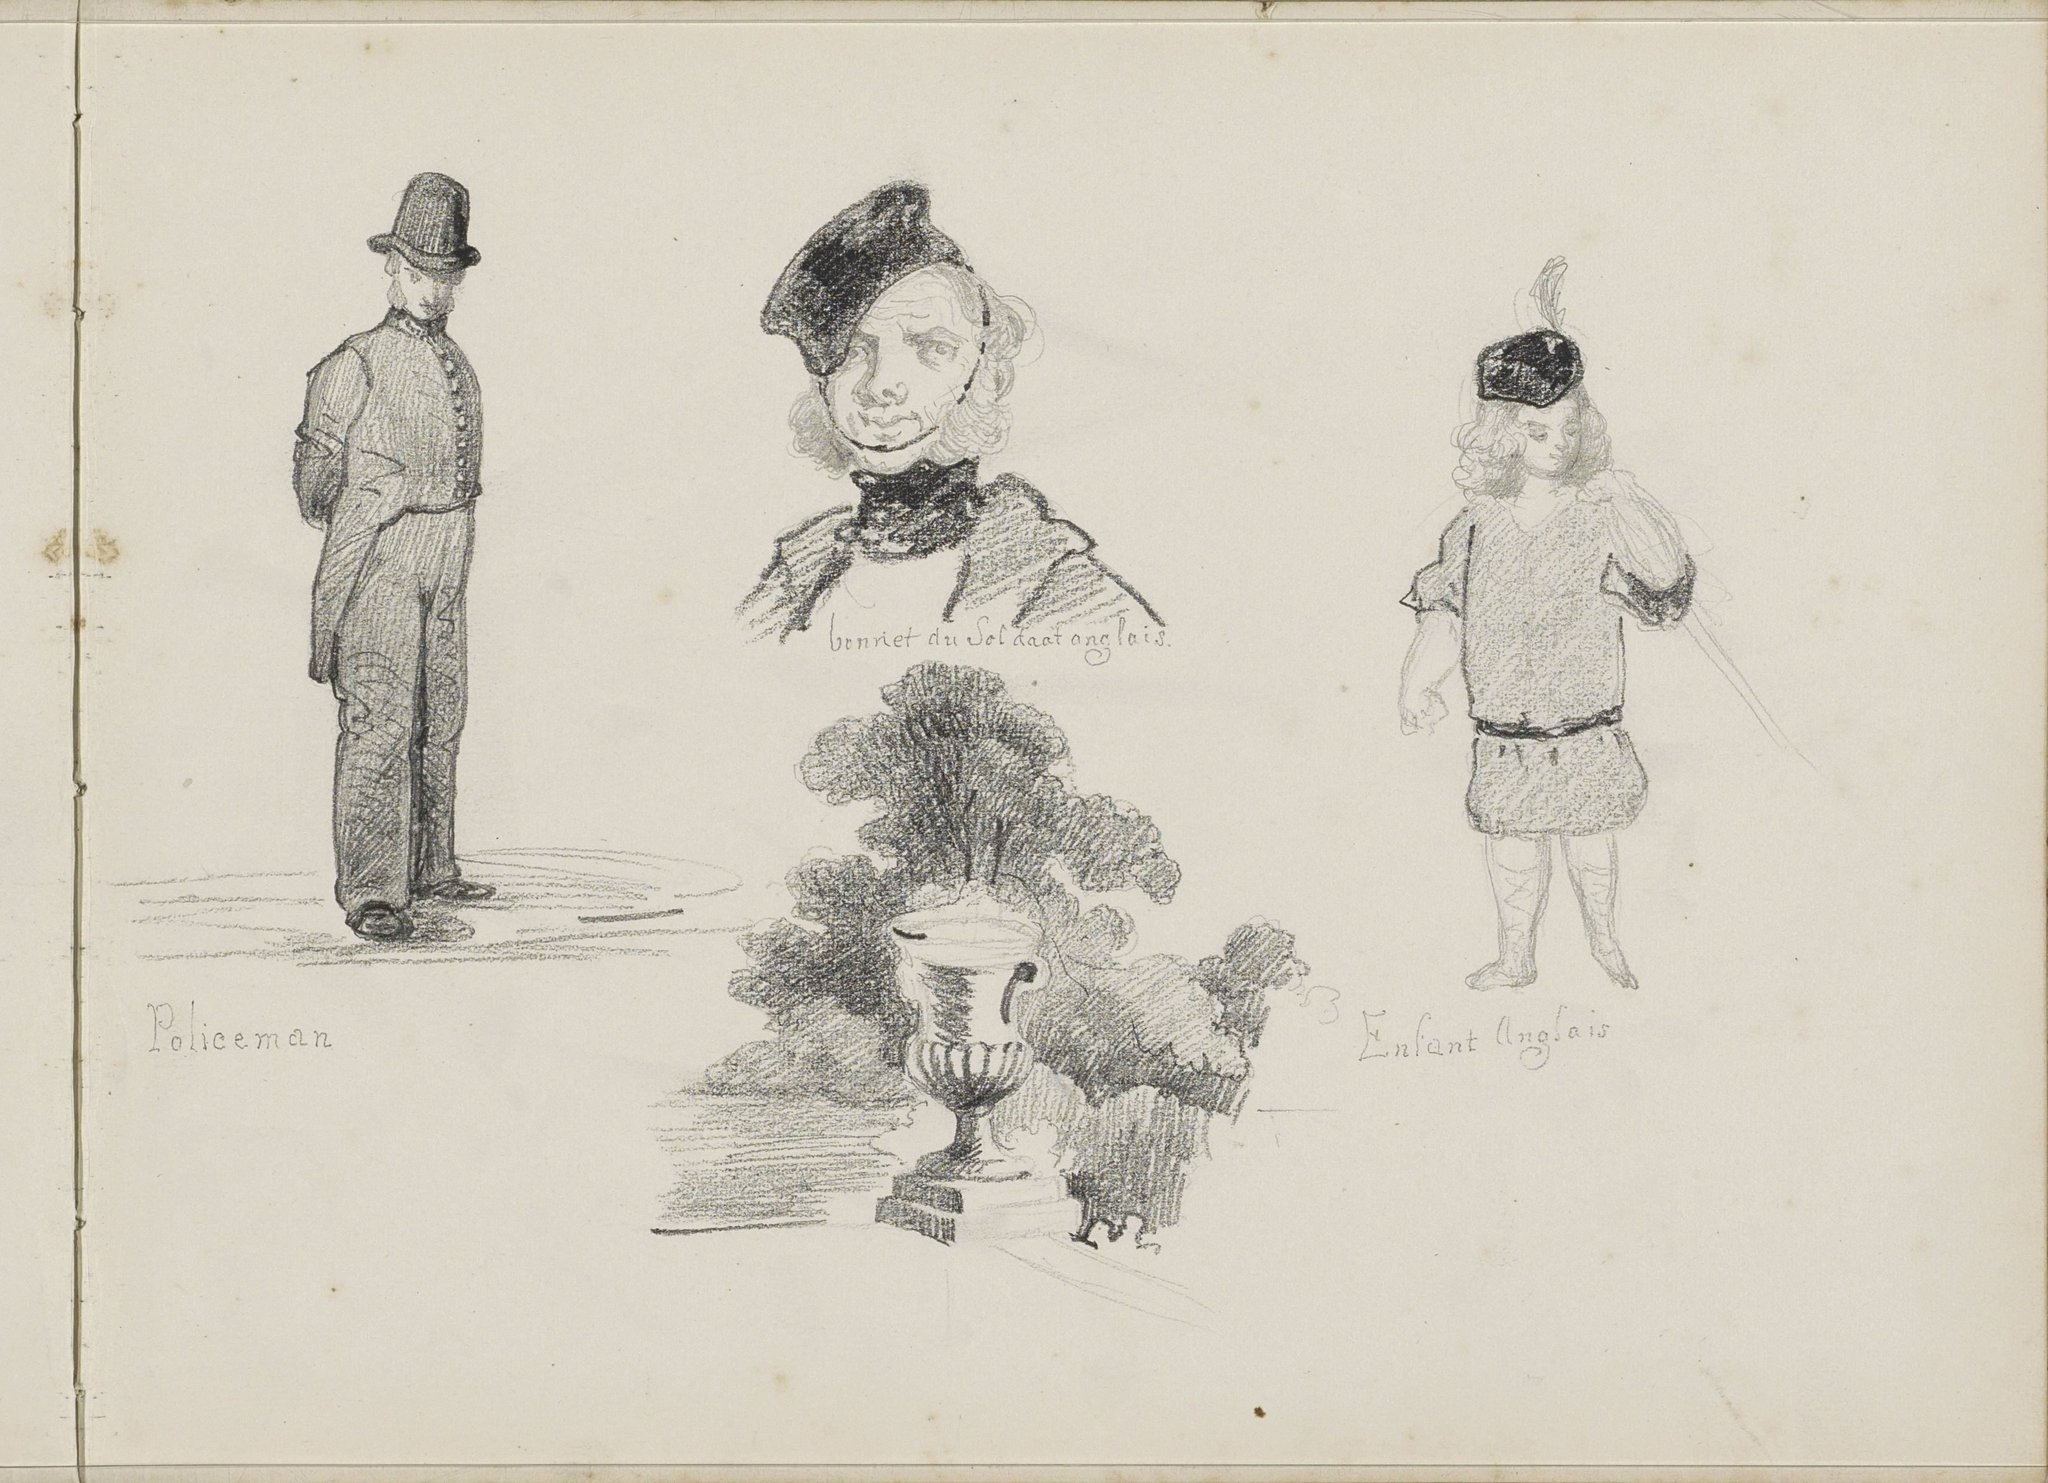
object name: sketchbook leaf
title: Engelse politieman en jongen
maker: gerrit postma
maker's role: draughtsman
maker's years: 1819-1894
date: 1858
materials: paper, pencil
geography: england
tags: child, head-gear: hat (+ men's clothes), policeman, constable, garden vase, england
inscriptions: annotation: ‘bonnet du Soldaat anglais./ Policeman/ Enfant Anglais’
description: Tevens een studie van de hoed van een Engelse soldaat en van een ornamentele vaas in een tuin. Blad 43 recto uit een schetsboek met 52 bladen.